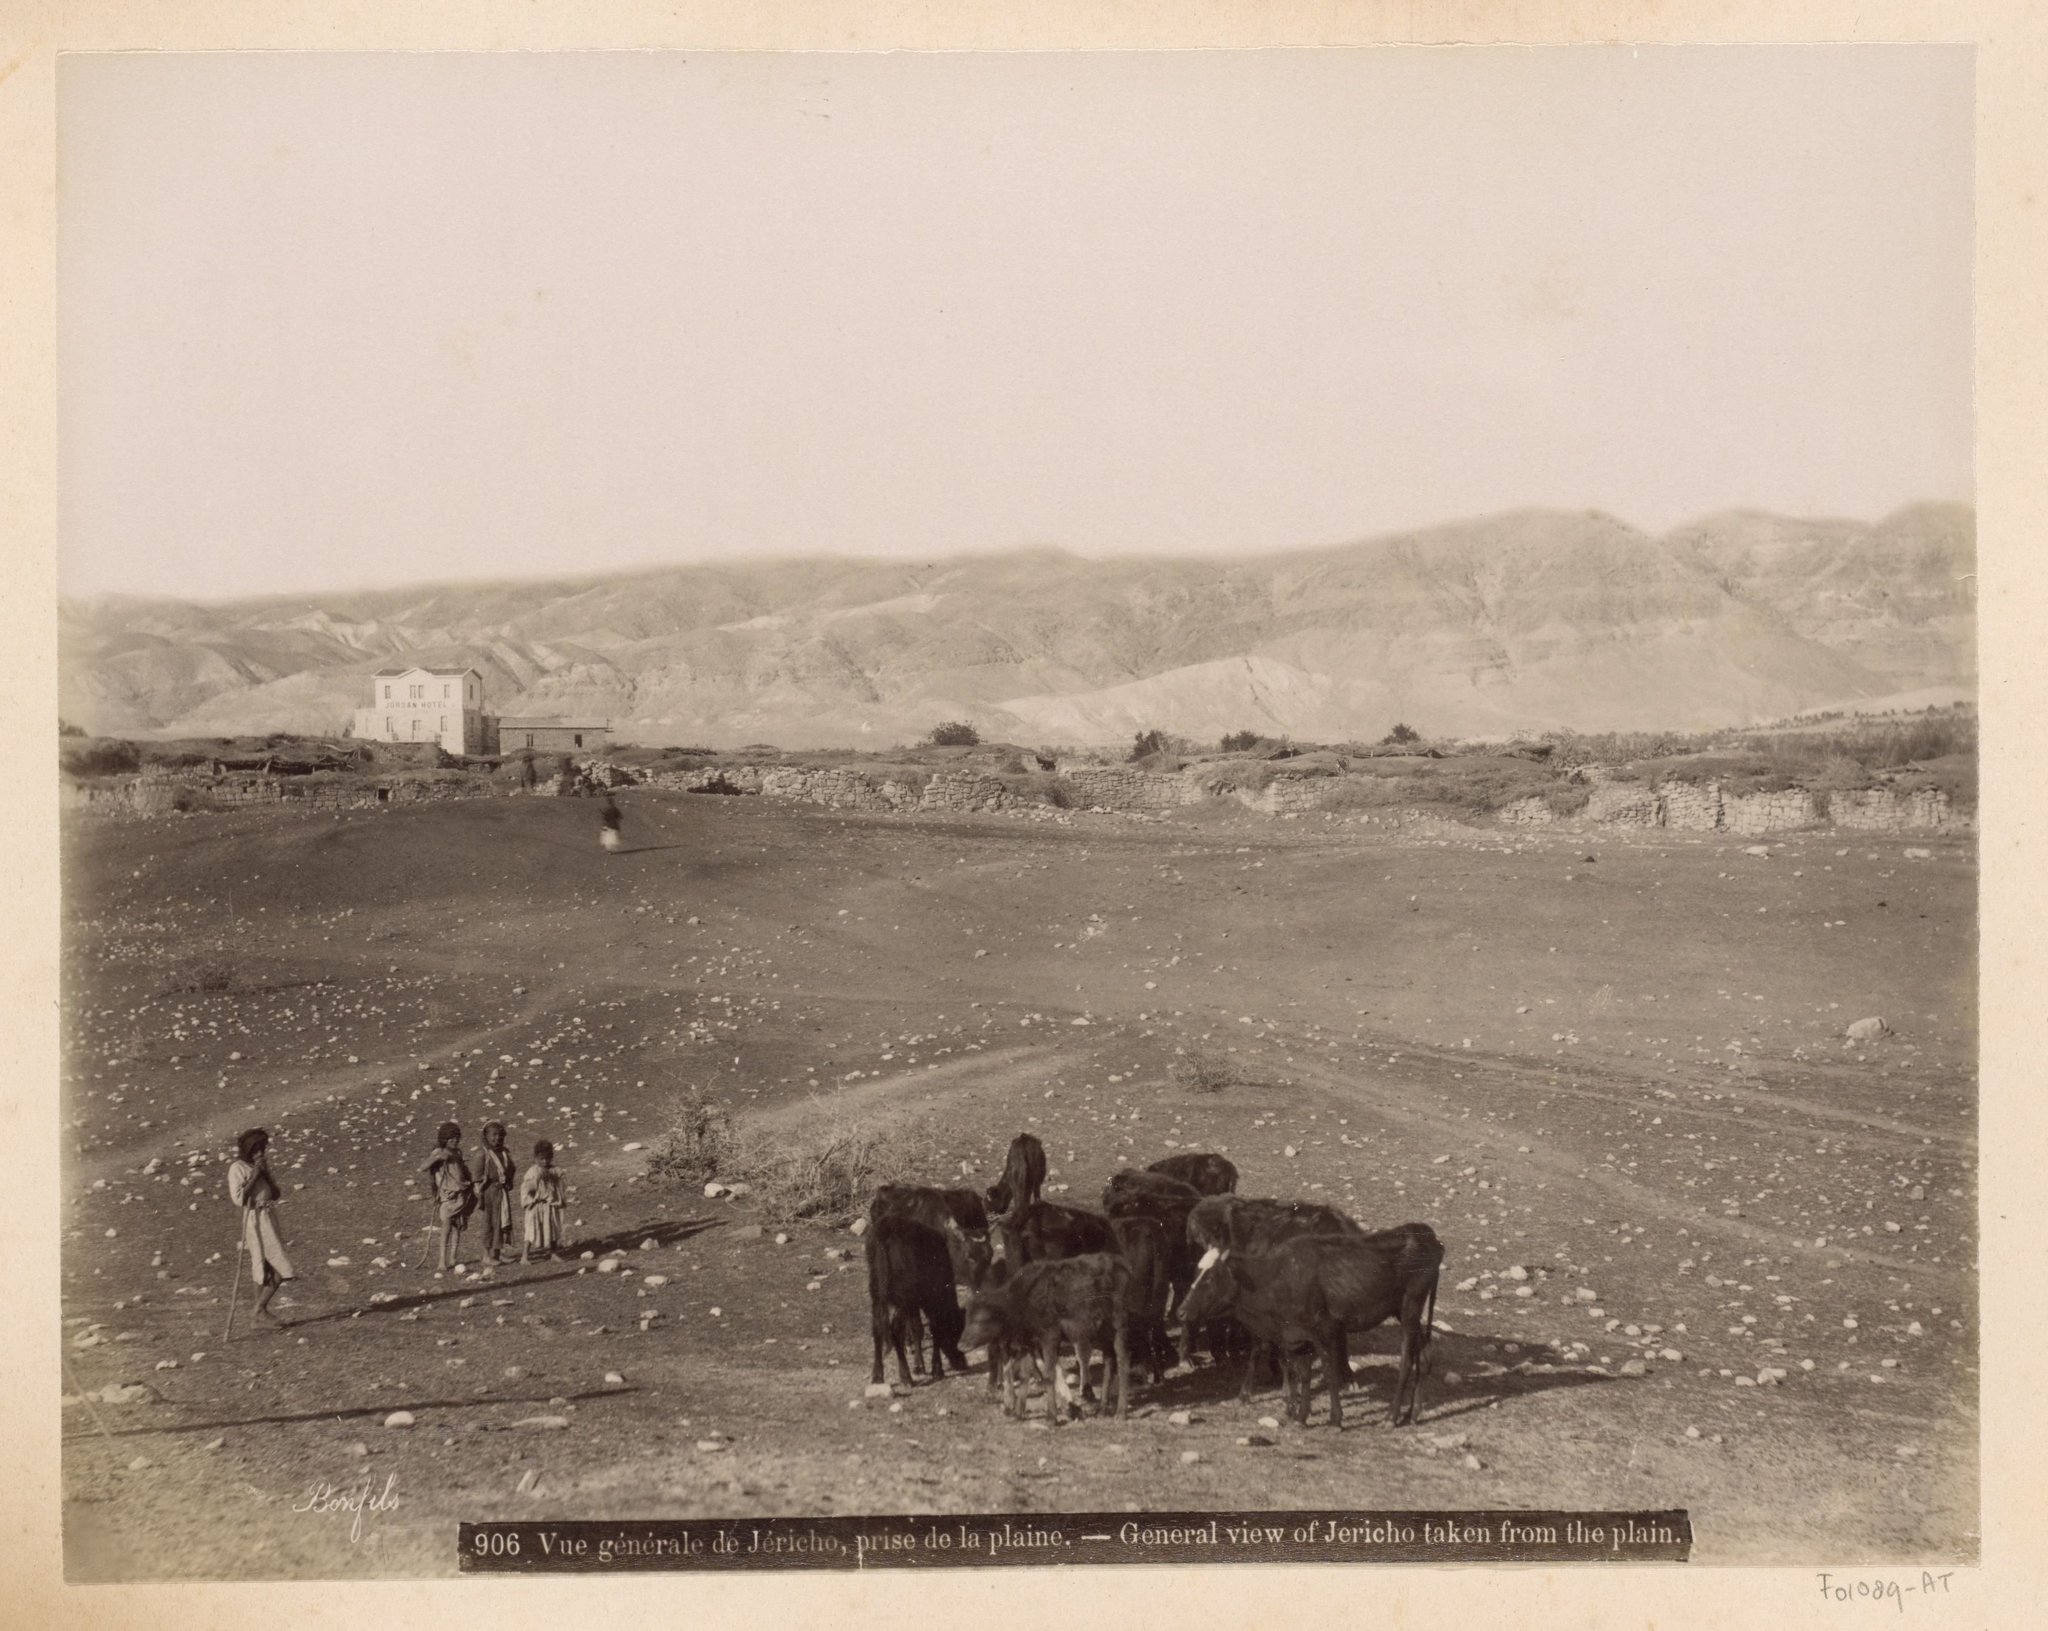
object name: photograph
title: Gezicht op Jericho vanaf de vlakte, links het Jordan Hotel, op de voorgrond kinderen met een kudde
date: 1867-1895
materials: cardboard, paper, photographic support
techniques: albumen print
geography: jericho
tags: herding, herdsman, herdswoman, shepherd, shepherdess, cowherd, etc., hotel, hostelry, inn, plain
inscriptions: negative number: ‘906’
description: Onderdeel van Reisalbum met foto's van Jeruzalem en andere bijbelse plaatsen.